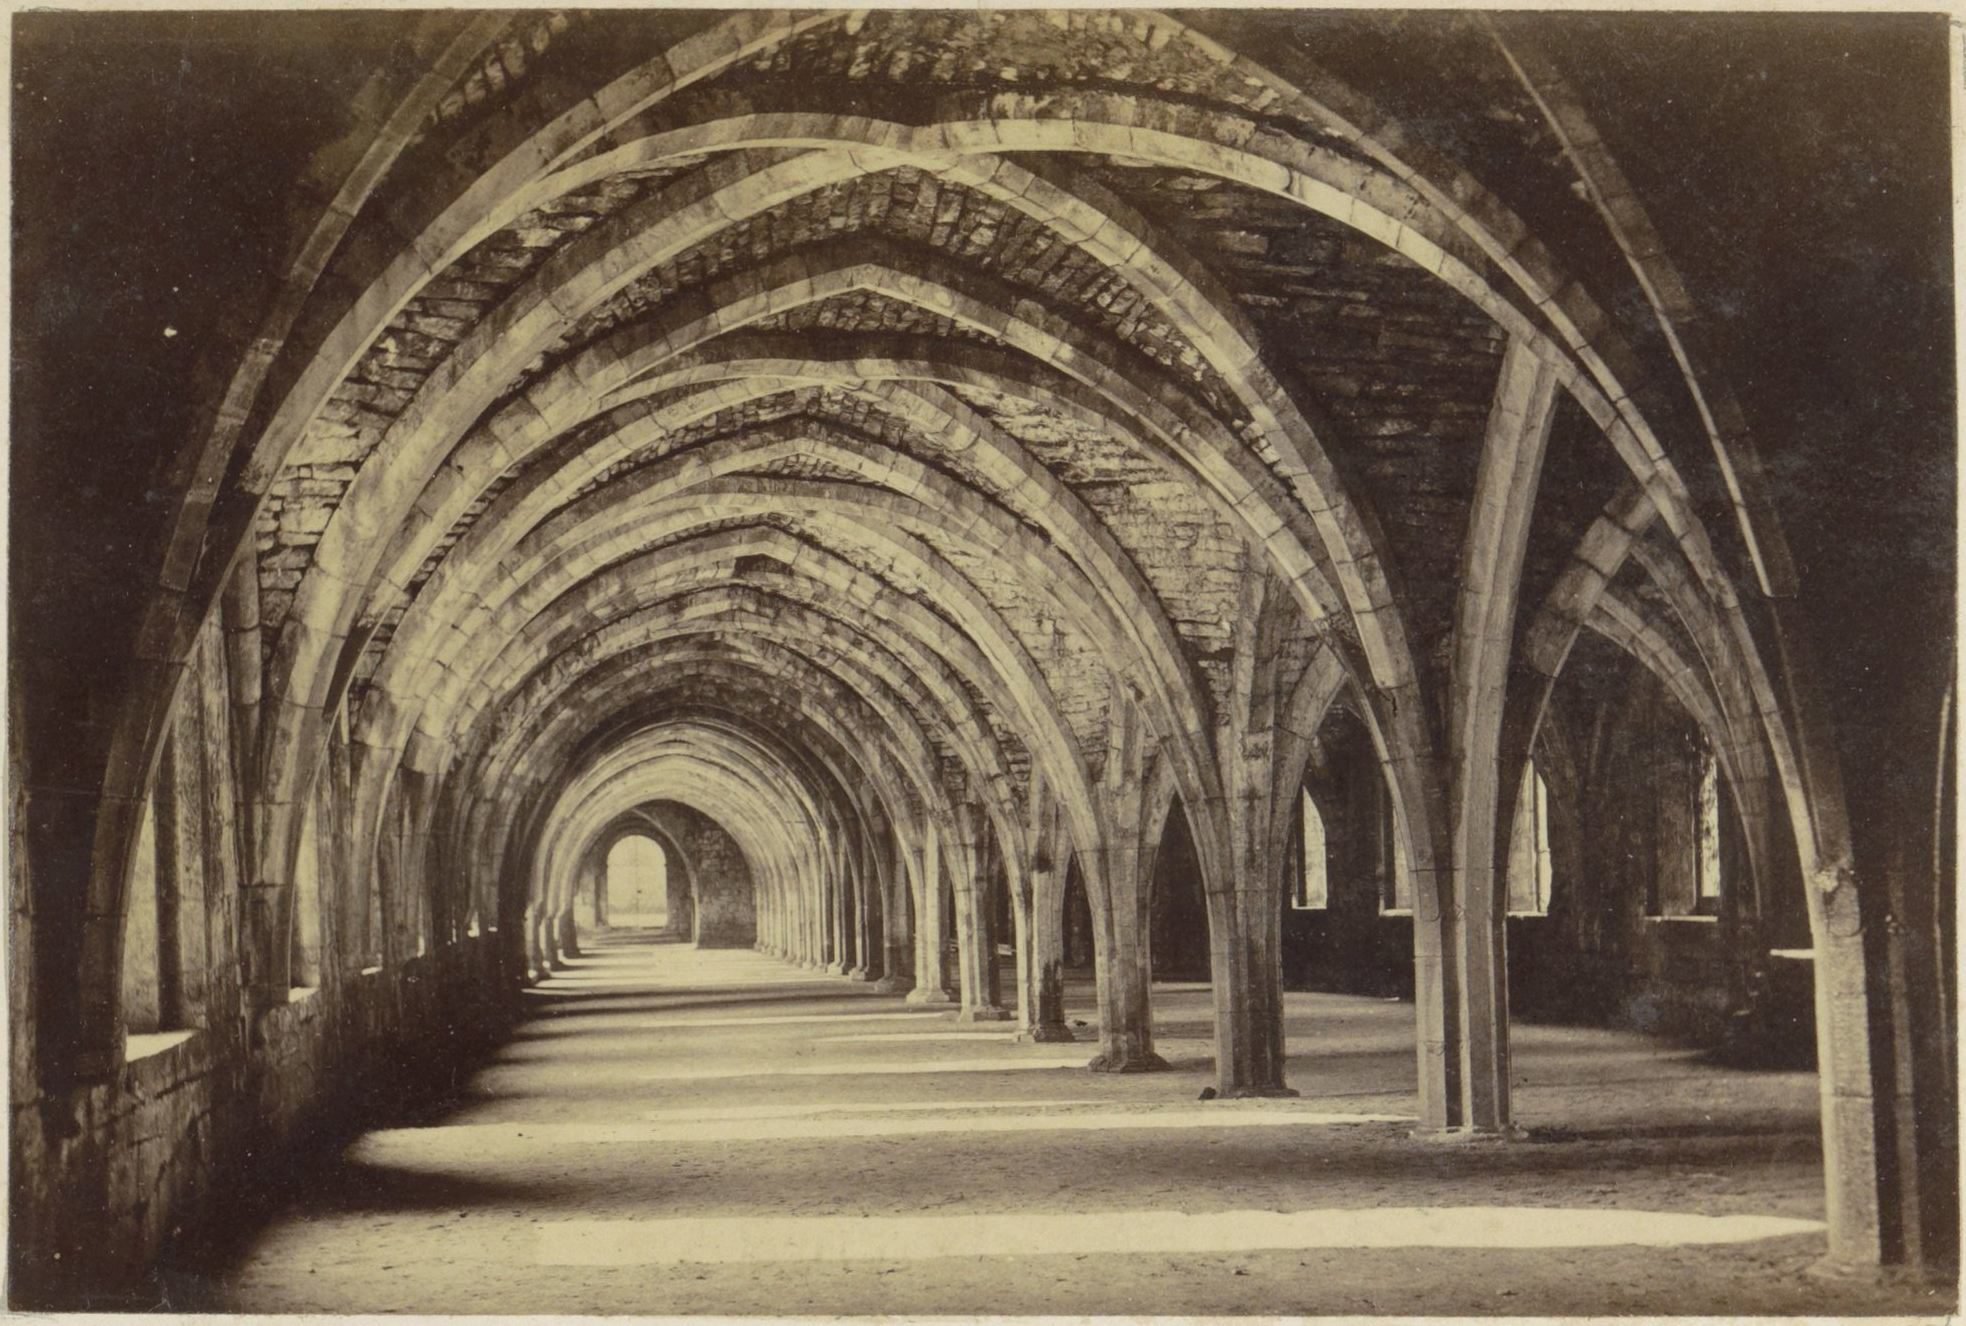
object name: photograph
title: Gewelven van een klooster in England, vermoedelijk Fountains Abbey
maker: Anonymous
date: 1850-1870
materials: paper, photographic support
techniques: albumen print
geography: yorkshire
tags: parts of church interior: vault, ruin of a dwelling, house, castle, etc.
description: Onderdeel van Album met foto's van bezienswaardigheden en landschappen in Engeland en van kunst.